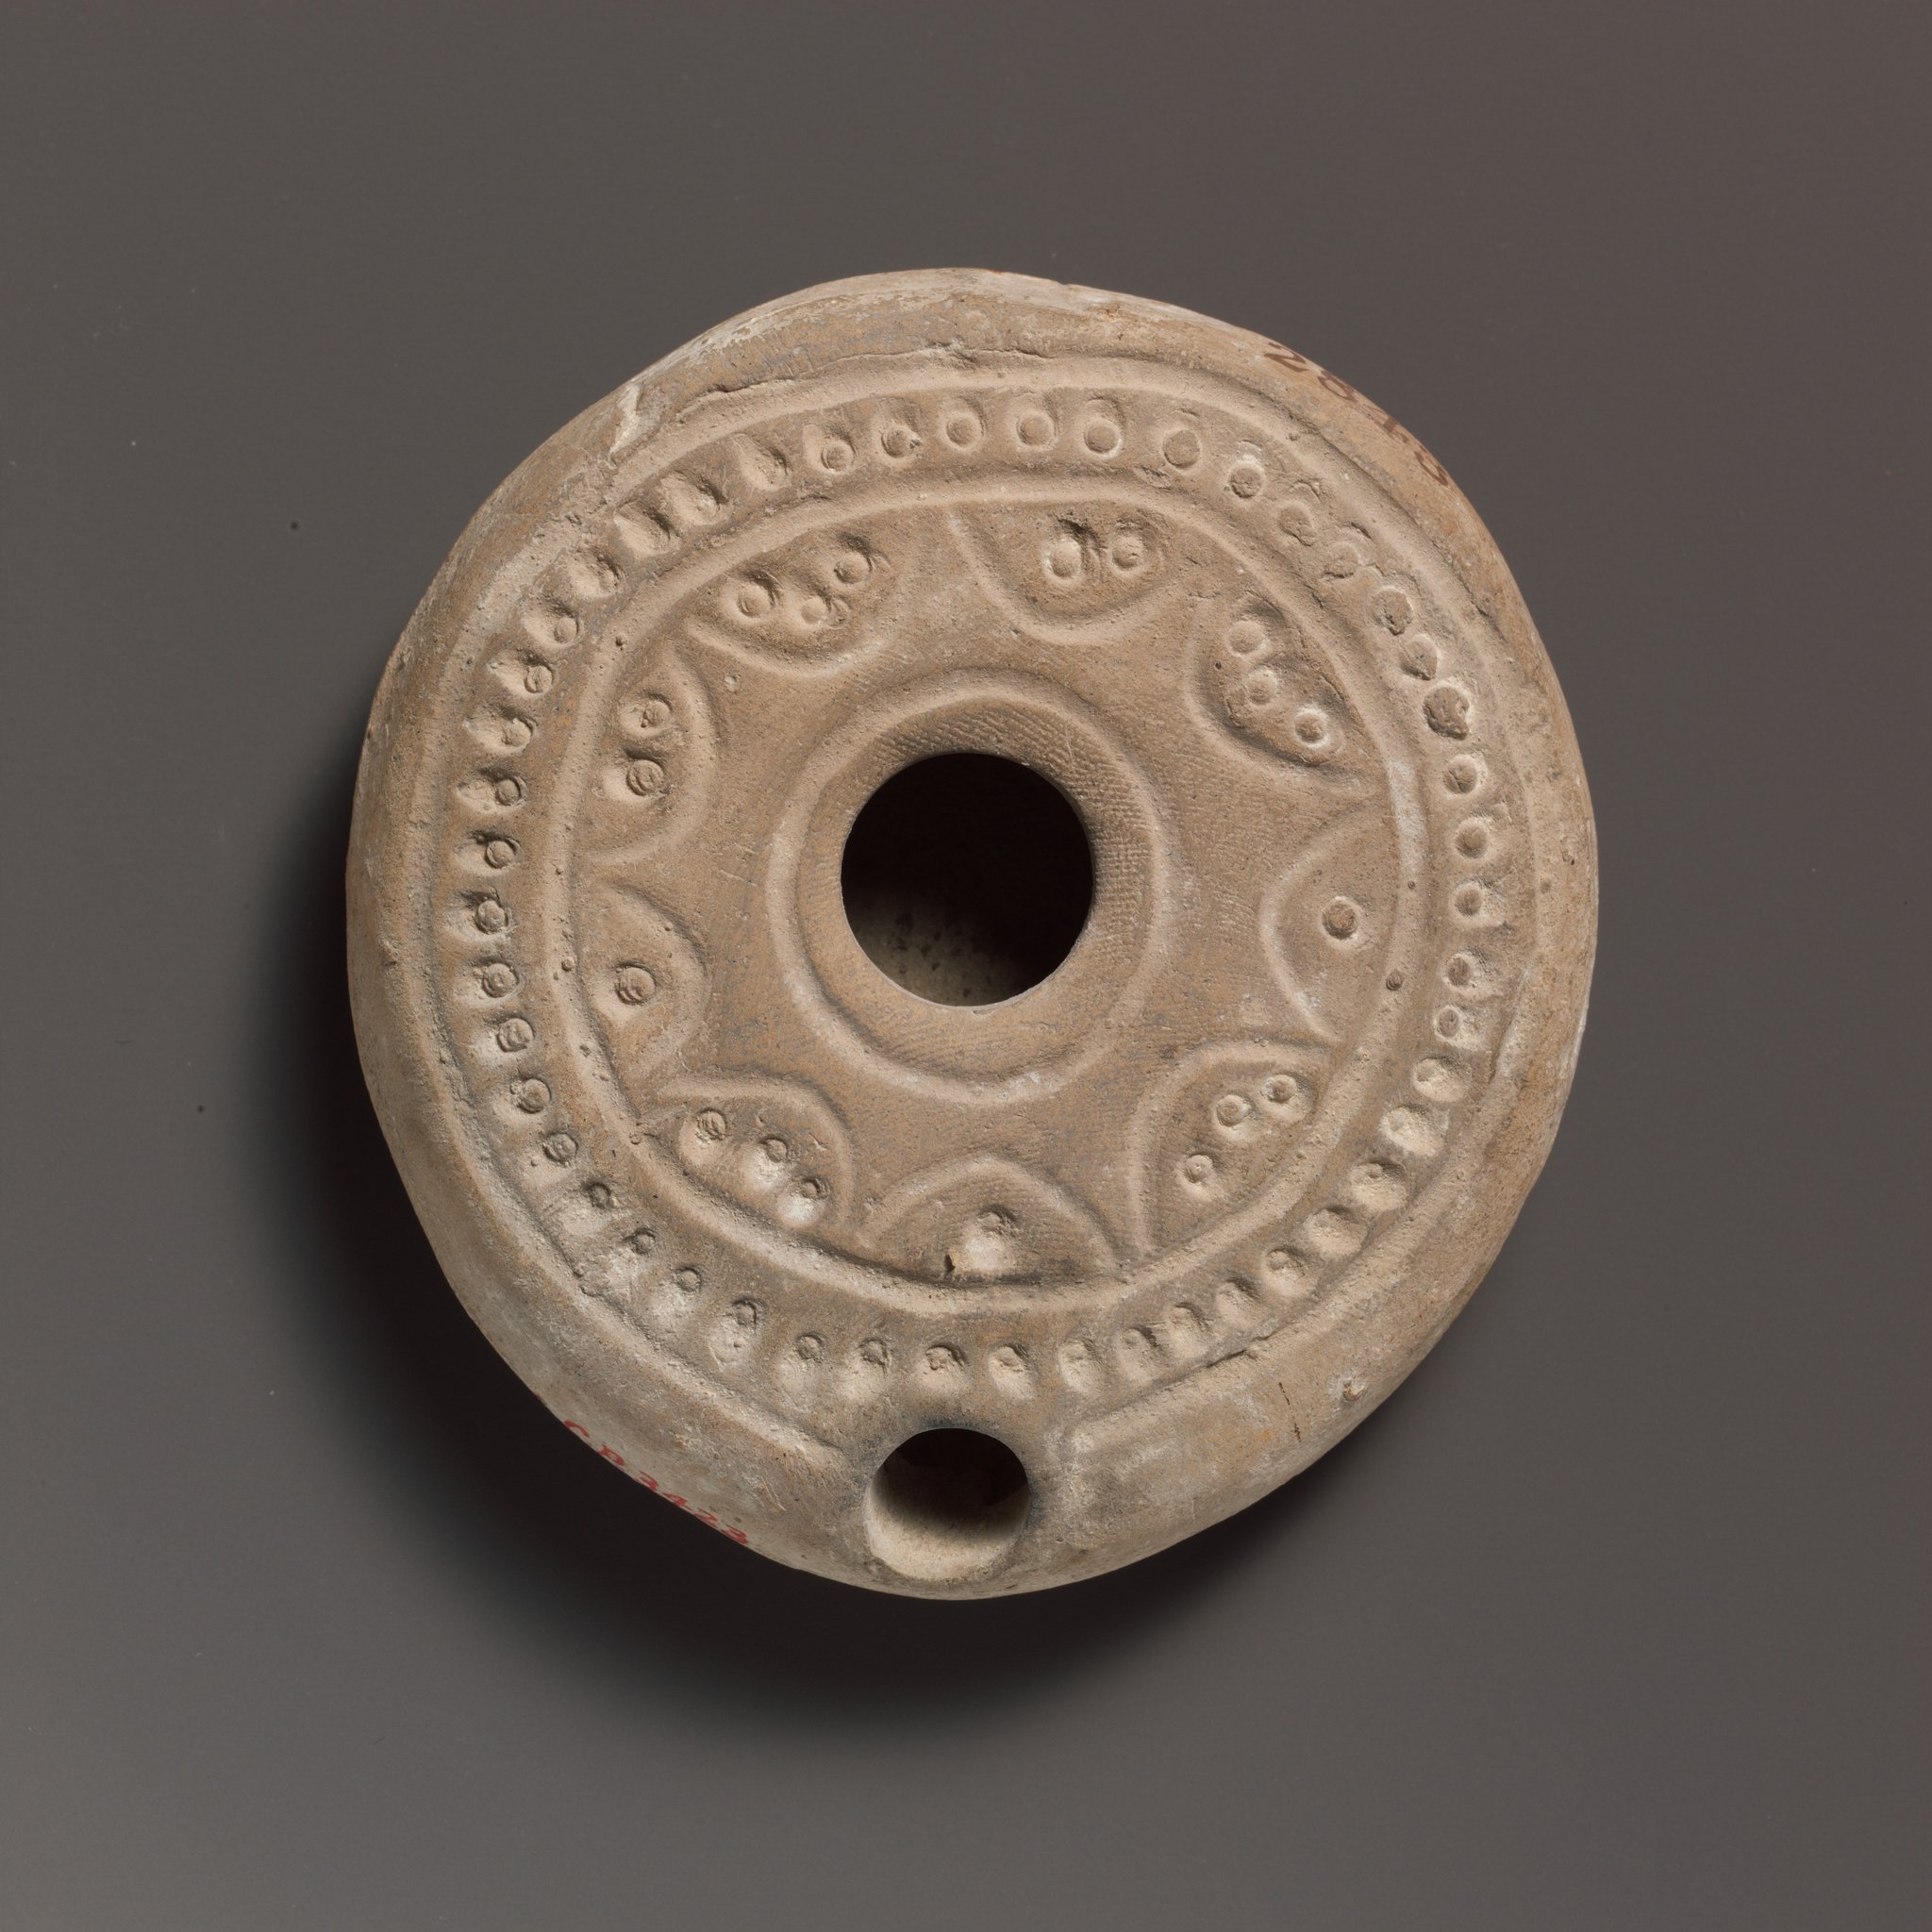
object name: lamp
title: Terracotta oil lamp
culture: roman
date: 467-600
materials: terracotta